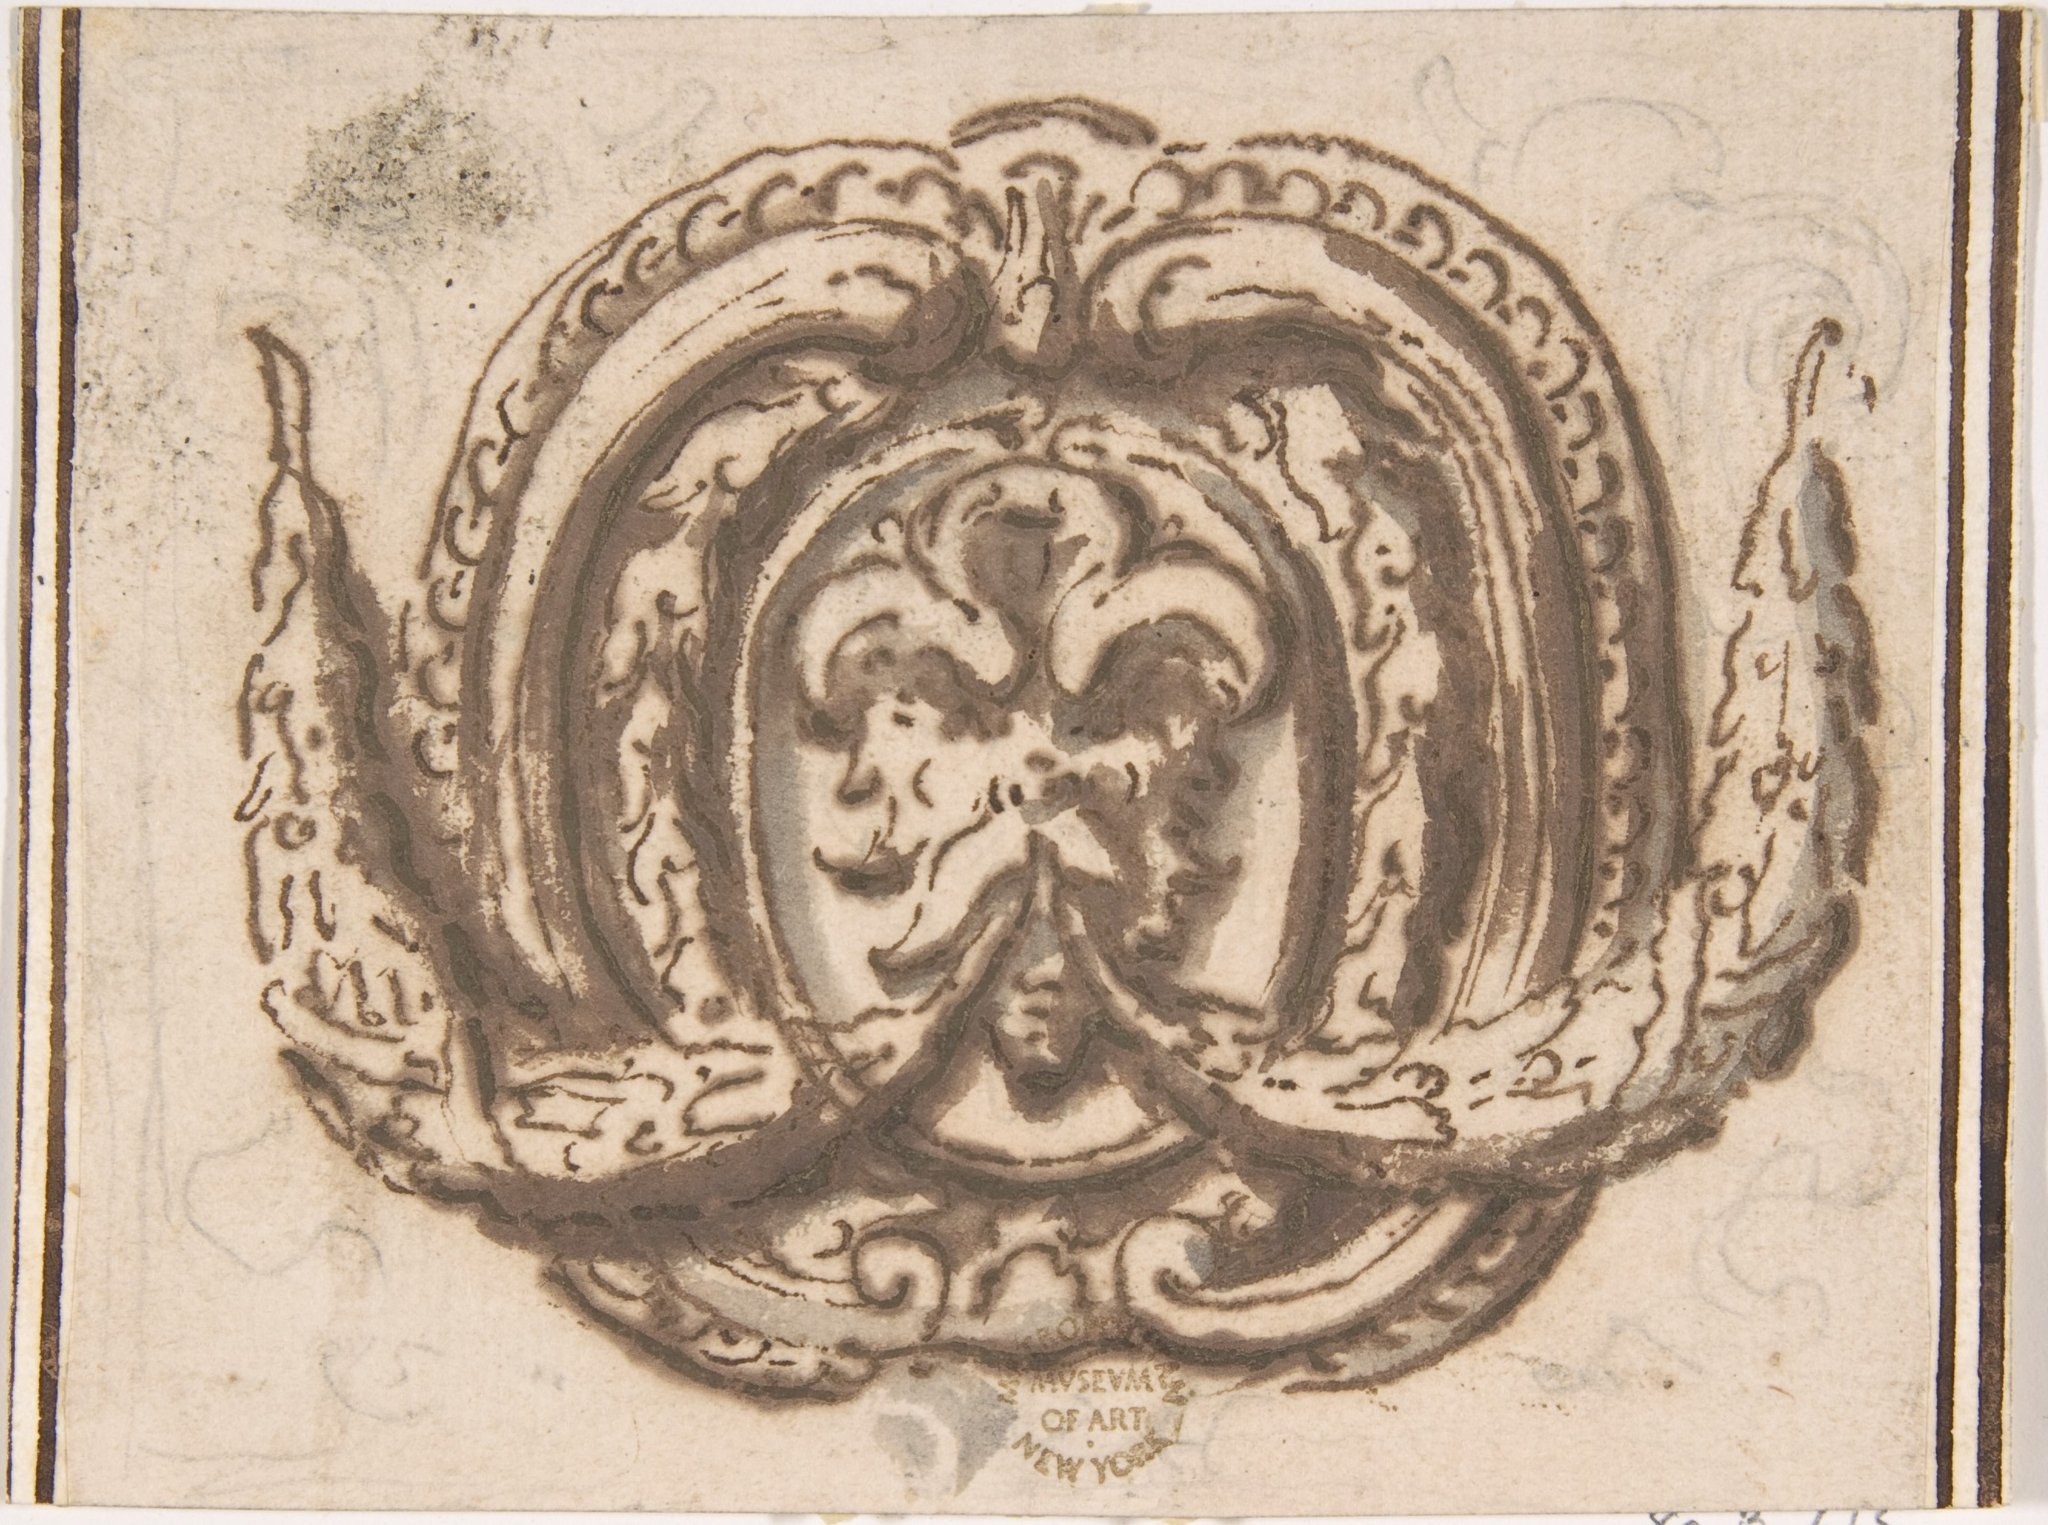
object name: drawing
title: Ornament for Cartouche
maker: anonymous, italian, 16th century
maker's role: artist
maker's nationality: italian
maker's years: 1550-1600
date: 1501-1600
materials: ink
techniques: pen, wash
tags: cartouches,ornament